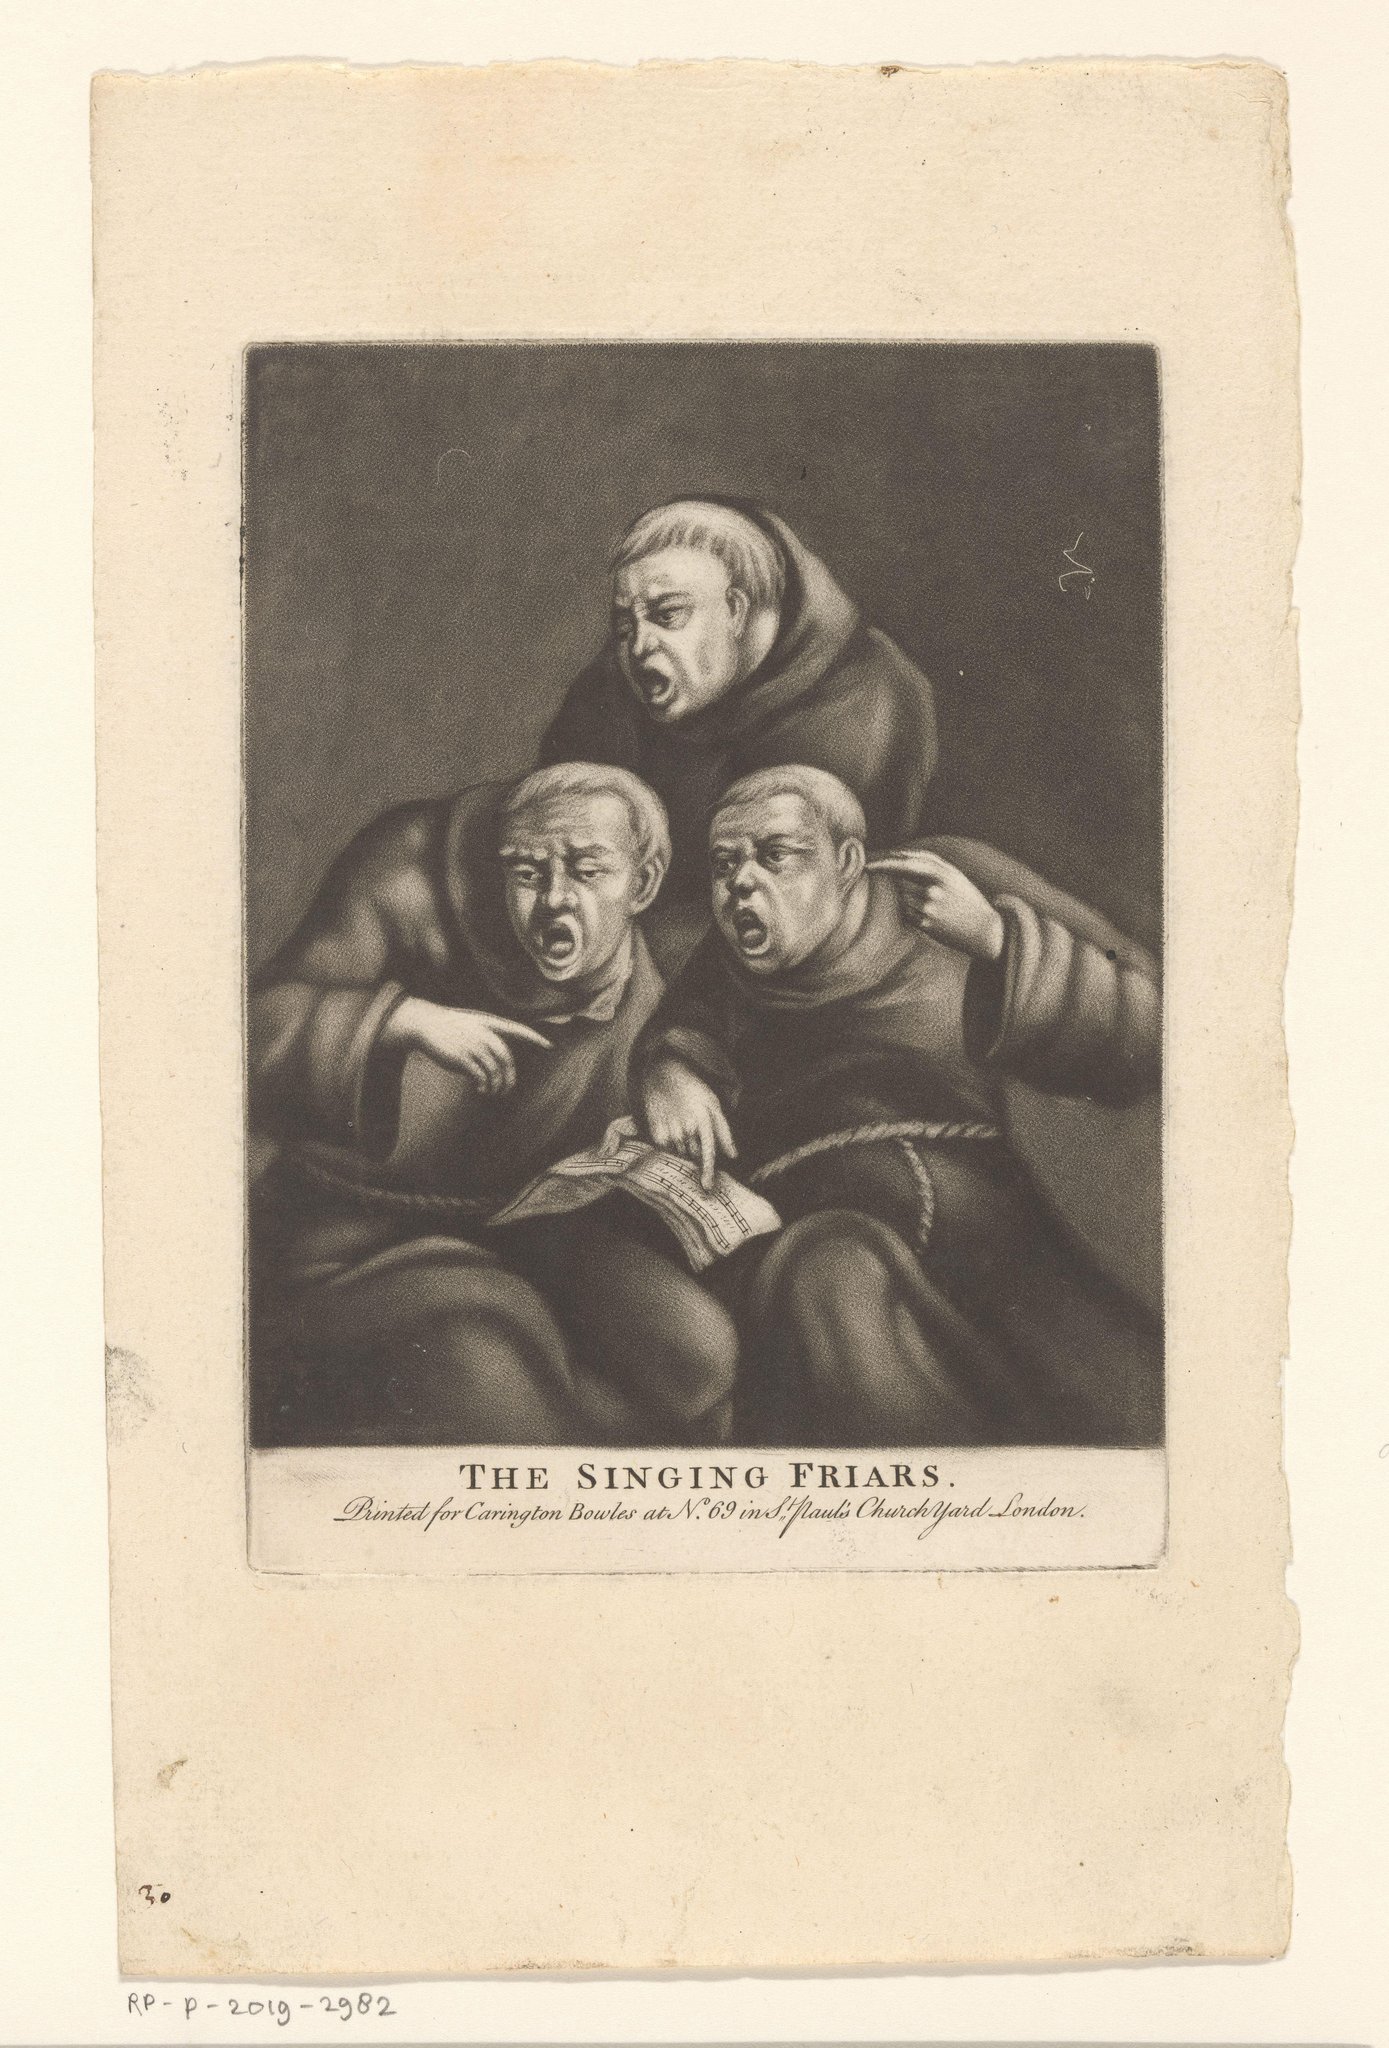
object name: print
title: The singing friars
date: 1734-1793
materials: paper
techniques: etching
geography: england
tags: singing of psalms, hymns, etc., monk(s), friar(s)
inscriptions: collector's mark: Lugt 2228, number: ‘30’